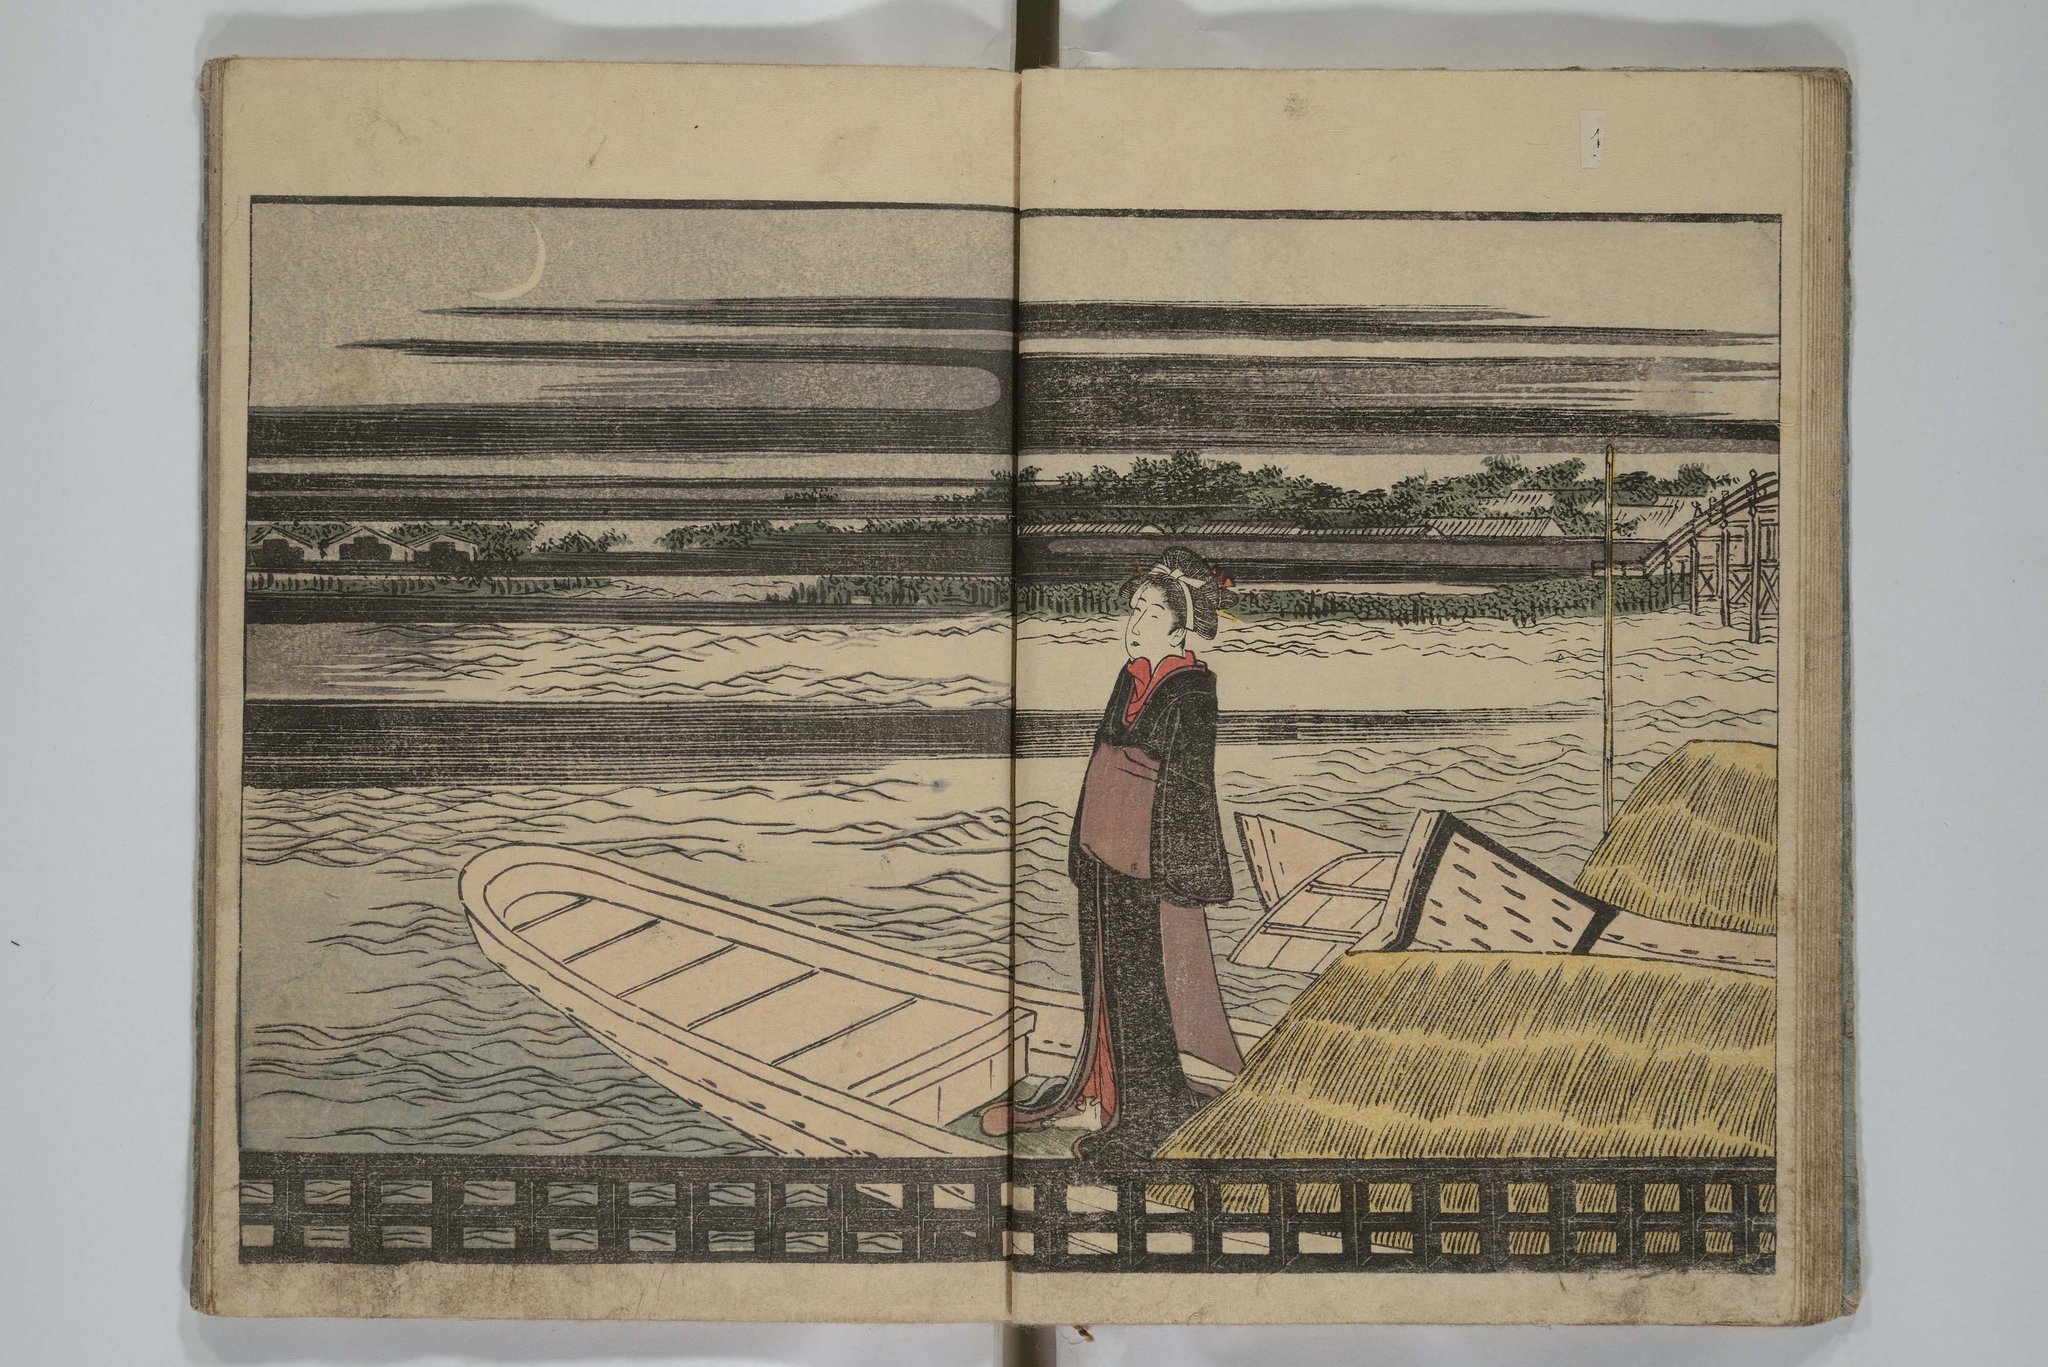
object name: illustrated book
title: Picture Book of Modern Figures of Fashion (Ehon imayō sugata) 絵本時世粧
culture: japanese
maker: utagawa toyokuni i 歌川豊国一世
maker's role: artist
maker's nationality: japanese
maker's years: 1769-1825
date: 1802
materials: ink, paper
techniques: woodblock print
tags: men,women,reading,working,musicians,boats